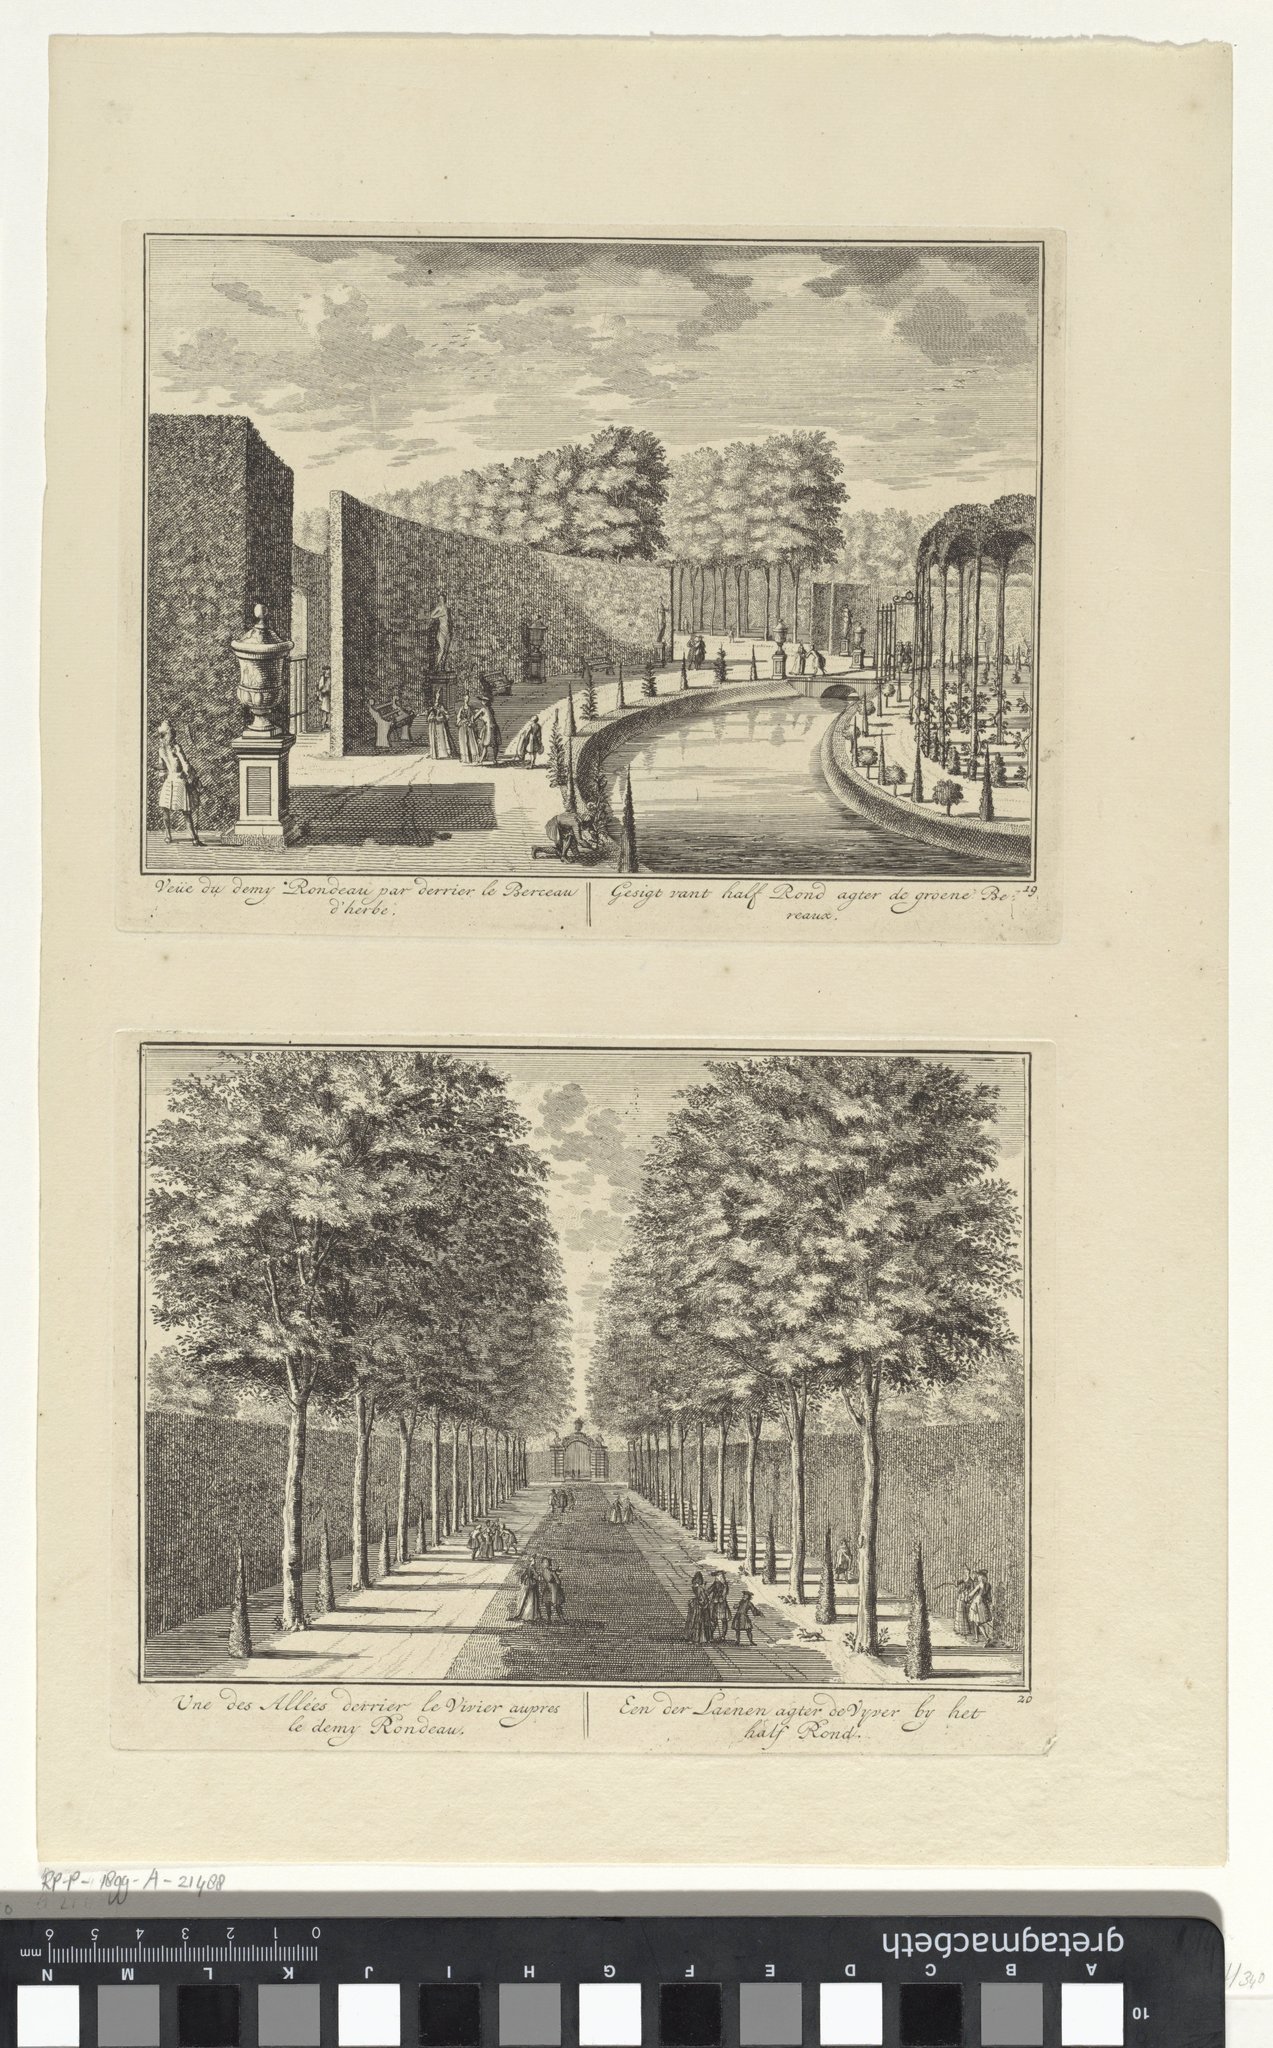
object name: print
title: Gesigt vant half Rond agter de groene Bereaux / Veüe du demy Rondeau par derrier le Berceau d'herbe / Een der Laenen agter de Vyver by het half Rond / Une des Allées derrier le Vivier aupres le demy Rondeau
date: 1682-1726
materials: paper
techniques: etching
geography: amsterdam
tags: french or architectonic garden; formal garden, water-works in garden, lane, alley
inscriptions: collector's mark: Lugt 2228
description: Twee voorstellingen op een blad. Boven: Gezicht op de halfronde afsluiting van de tuin achter Slot Zeist, uit het noordoosten. Onder: Gezicht in de centrale laan van het park achter de tuin bij Slot Zeist, uit het zuidwesten.